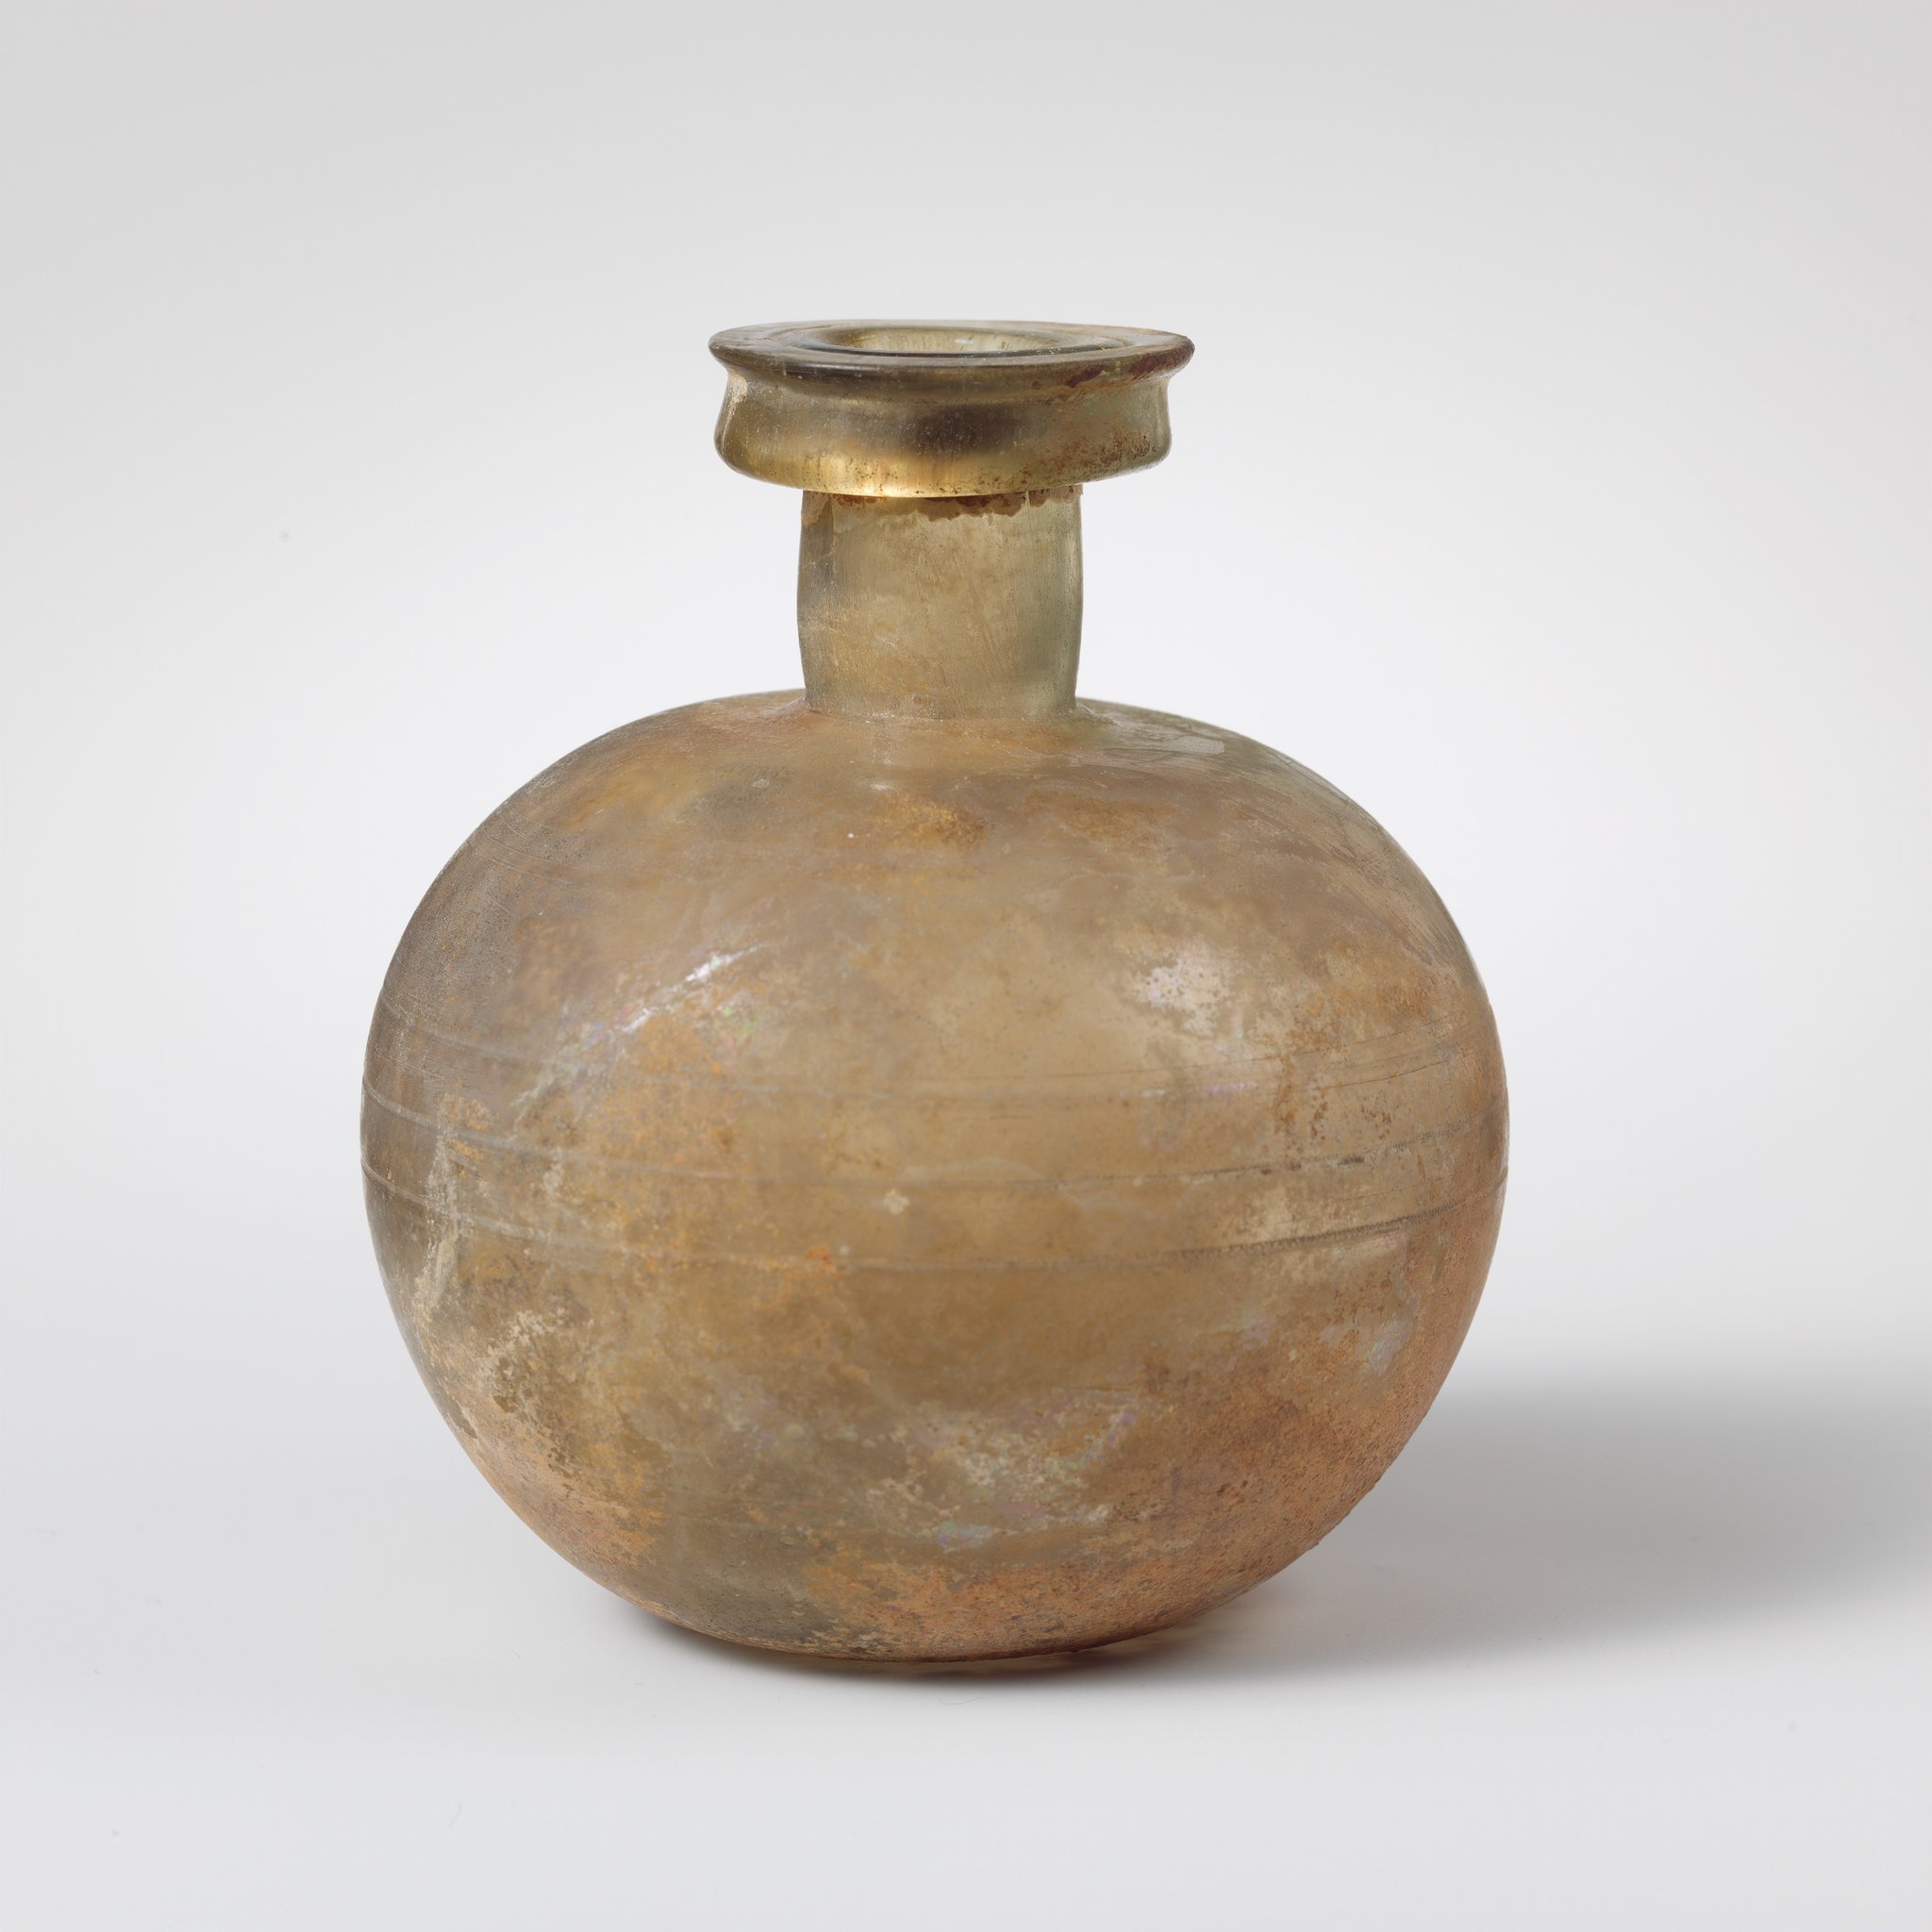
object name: bottle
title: Glass globular bottle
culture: roman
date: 1-200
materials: glass